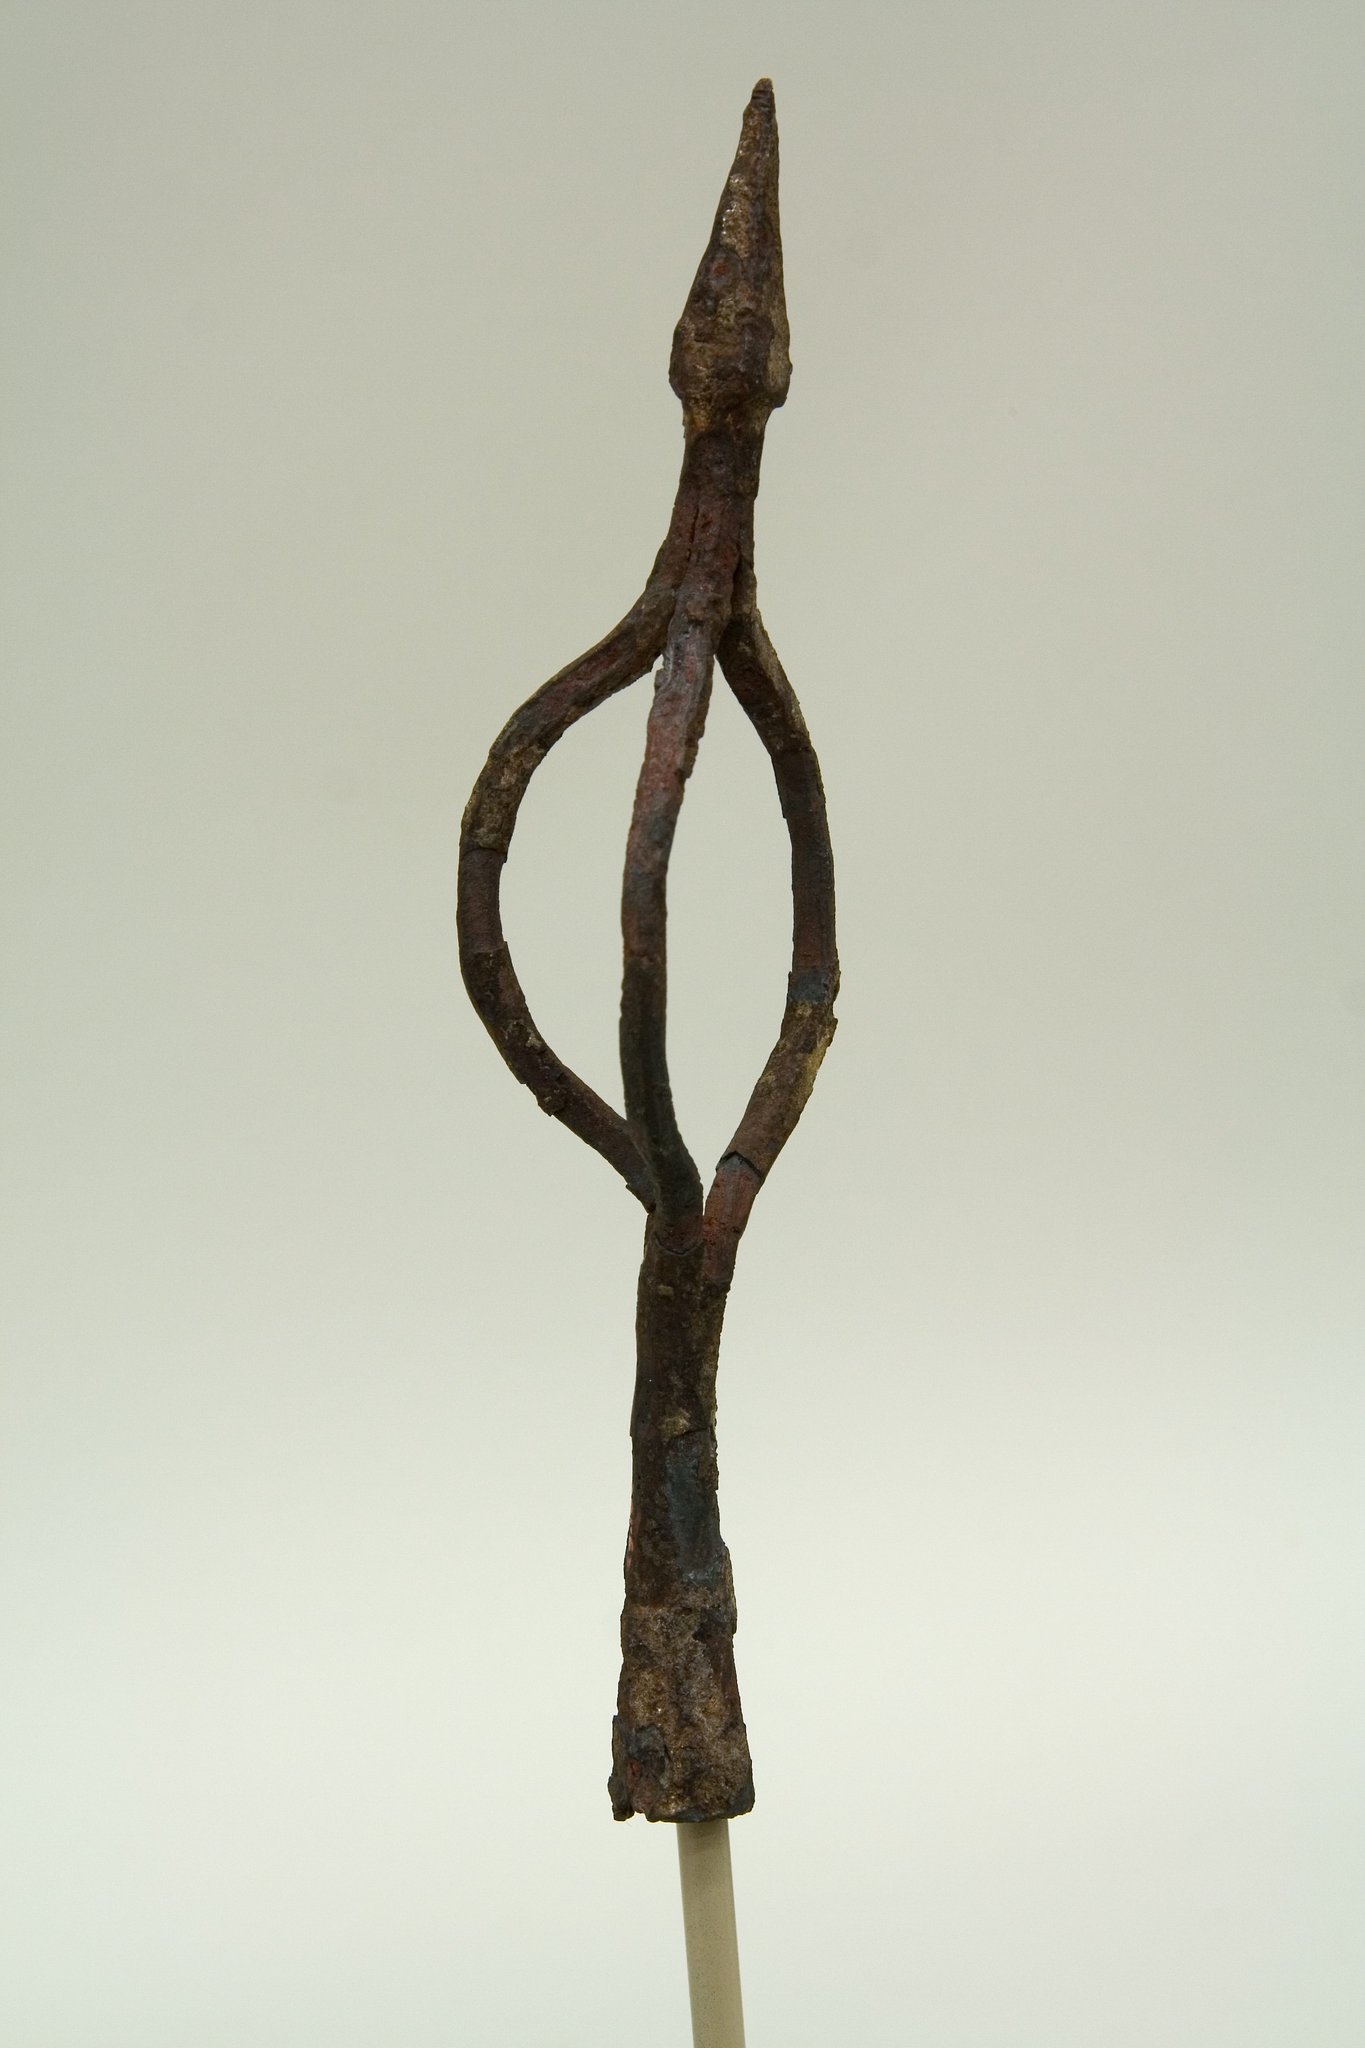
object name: arrowhead for an incendiary arrow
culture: roman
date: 101-200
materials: metal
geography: austria